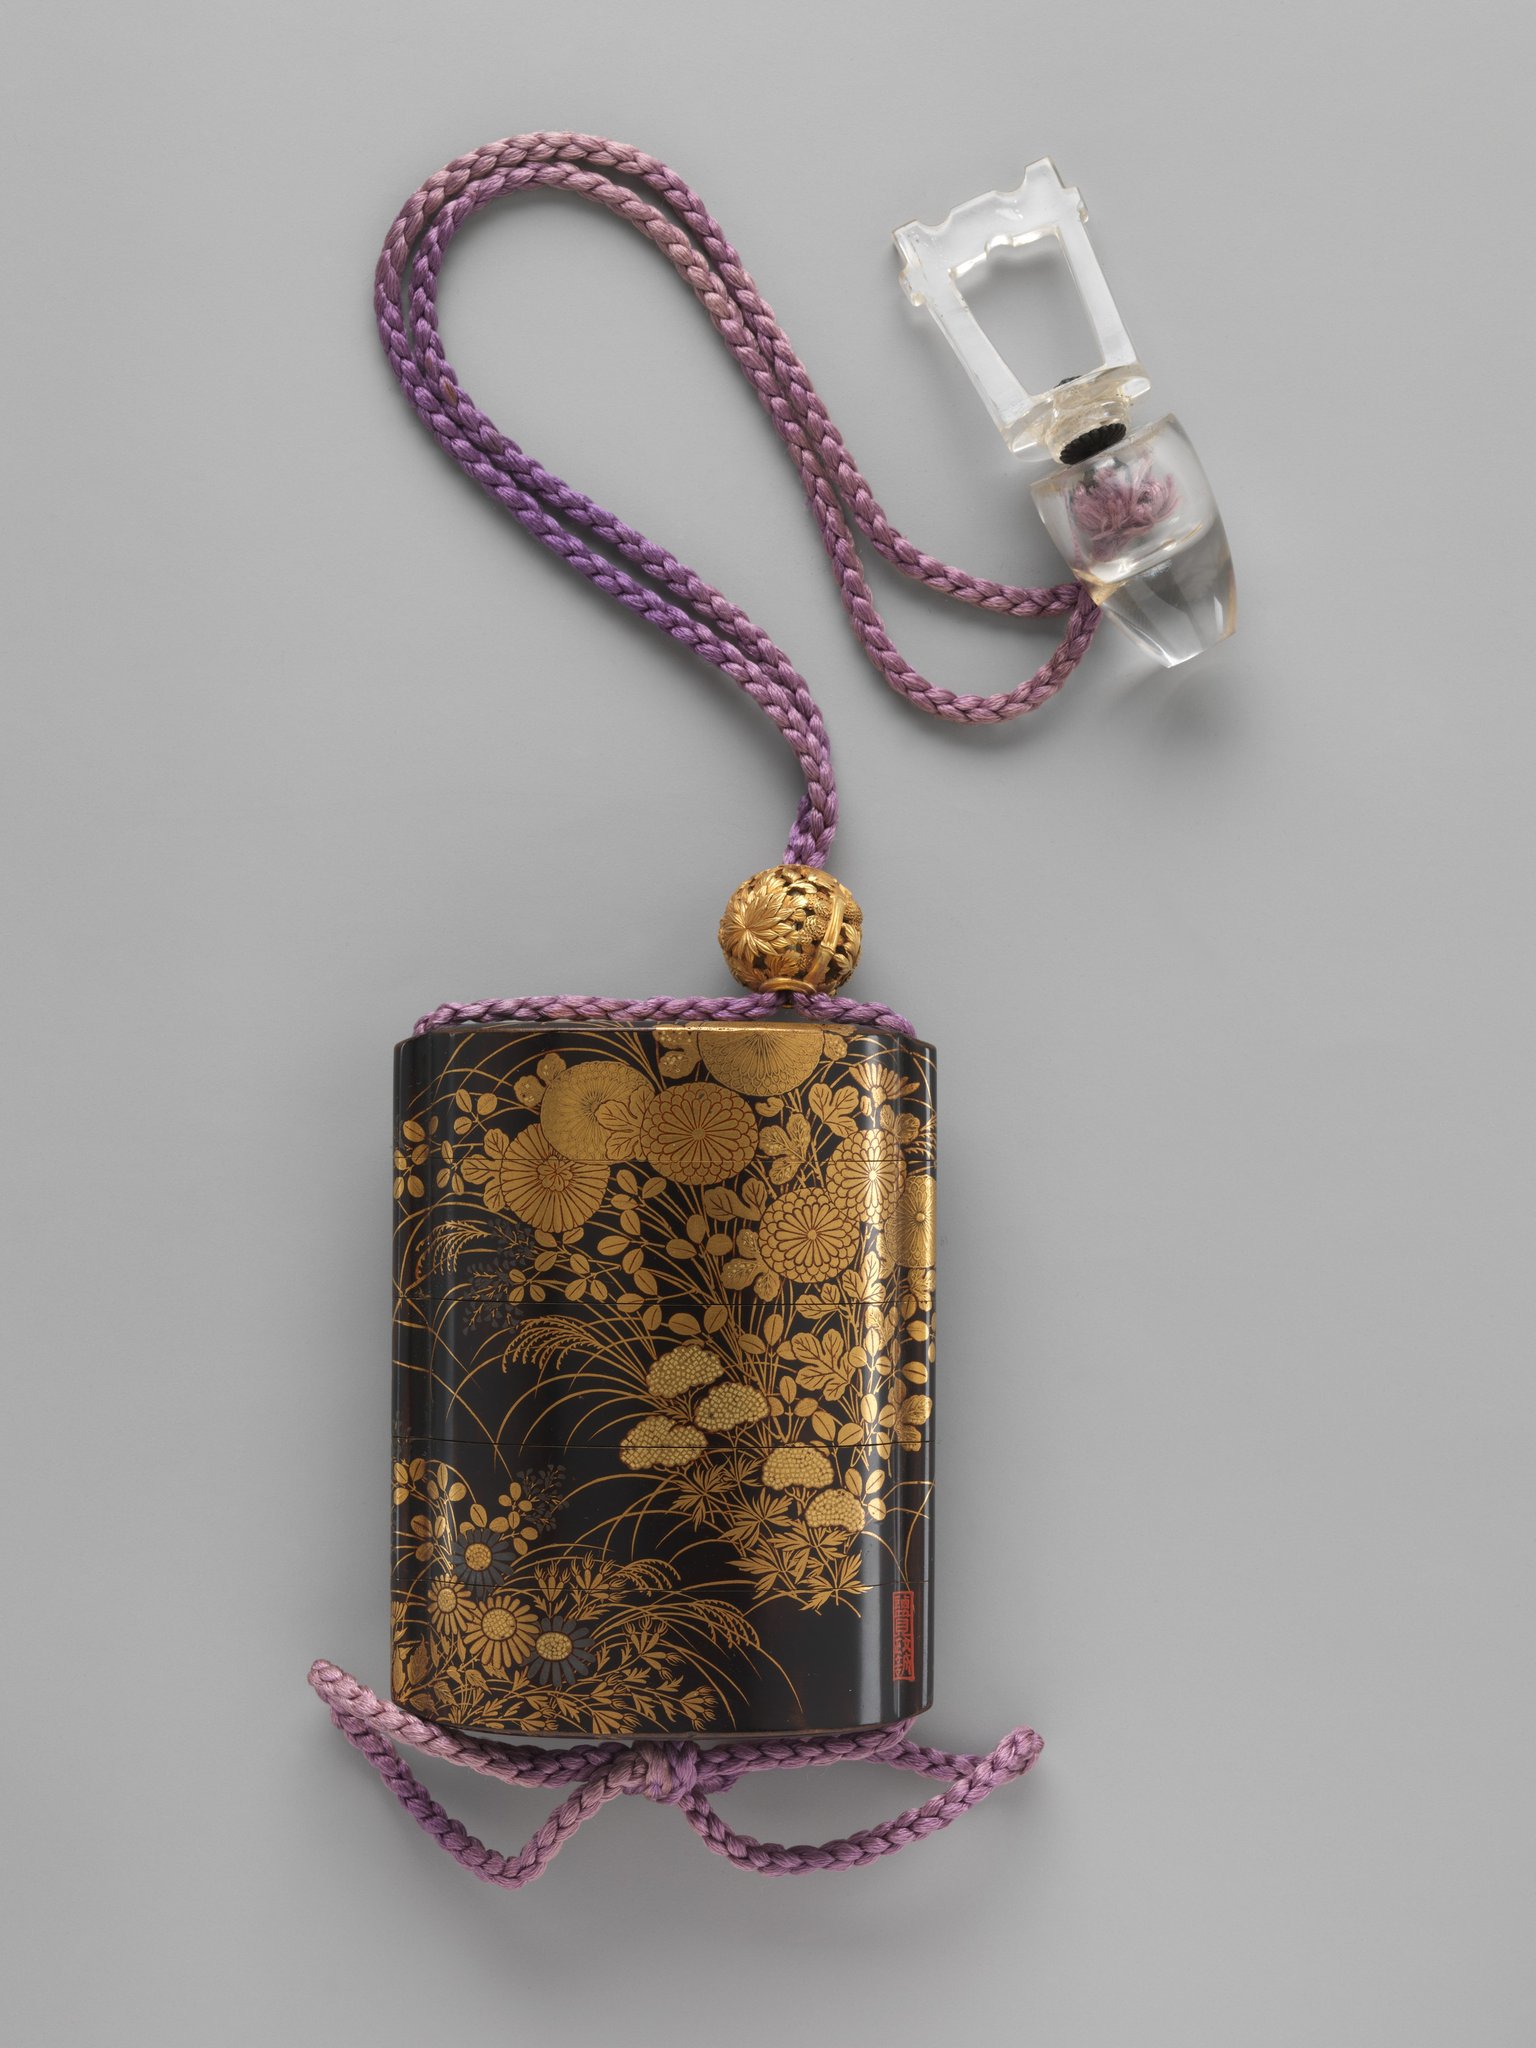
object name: inrō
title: Case (Inrō) with Design of Autumn Flowers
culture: japanese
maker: shiomi masanari 塩見政誠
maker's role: artist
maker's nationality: japanese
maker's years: 1646-1719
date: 1701-1733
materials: crystal, gold, lacquer, silver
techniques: carving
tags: flowers